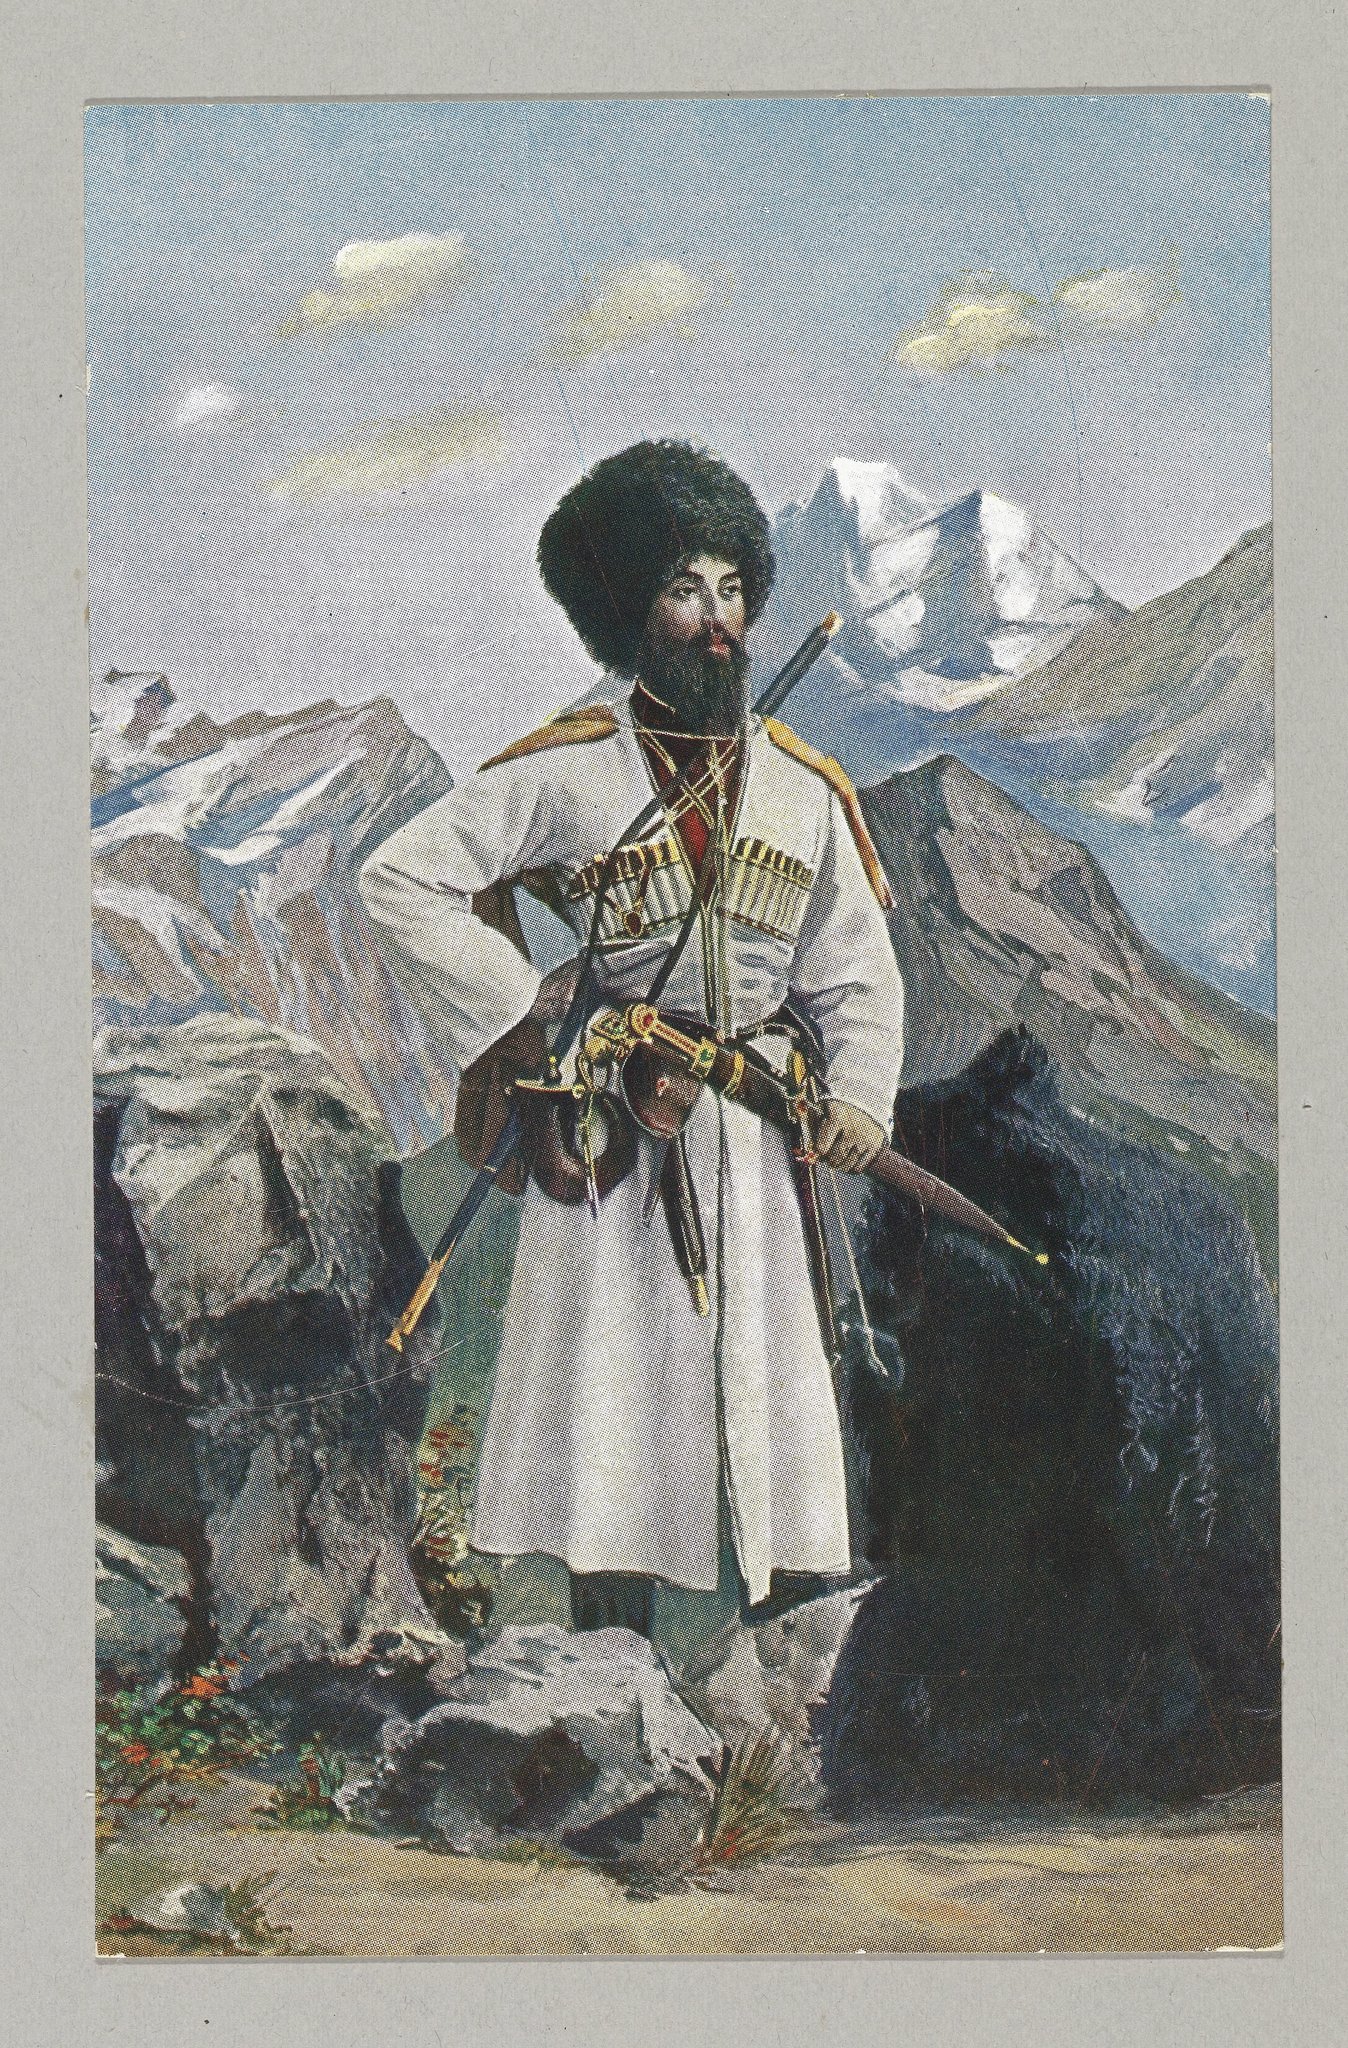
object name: photograph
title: Gewapende Kaukasische man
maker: Anonymous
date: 1895-1915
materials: cardboard, paper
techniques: autotype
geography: caucasus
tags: kaukasus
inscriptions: annotation: ‘32. Caucasiërs’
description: Man met wapens staand in een berglandschap.